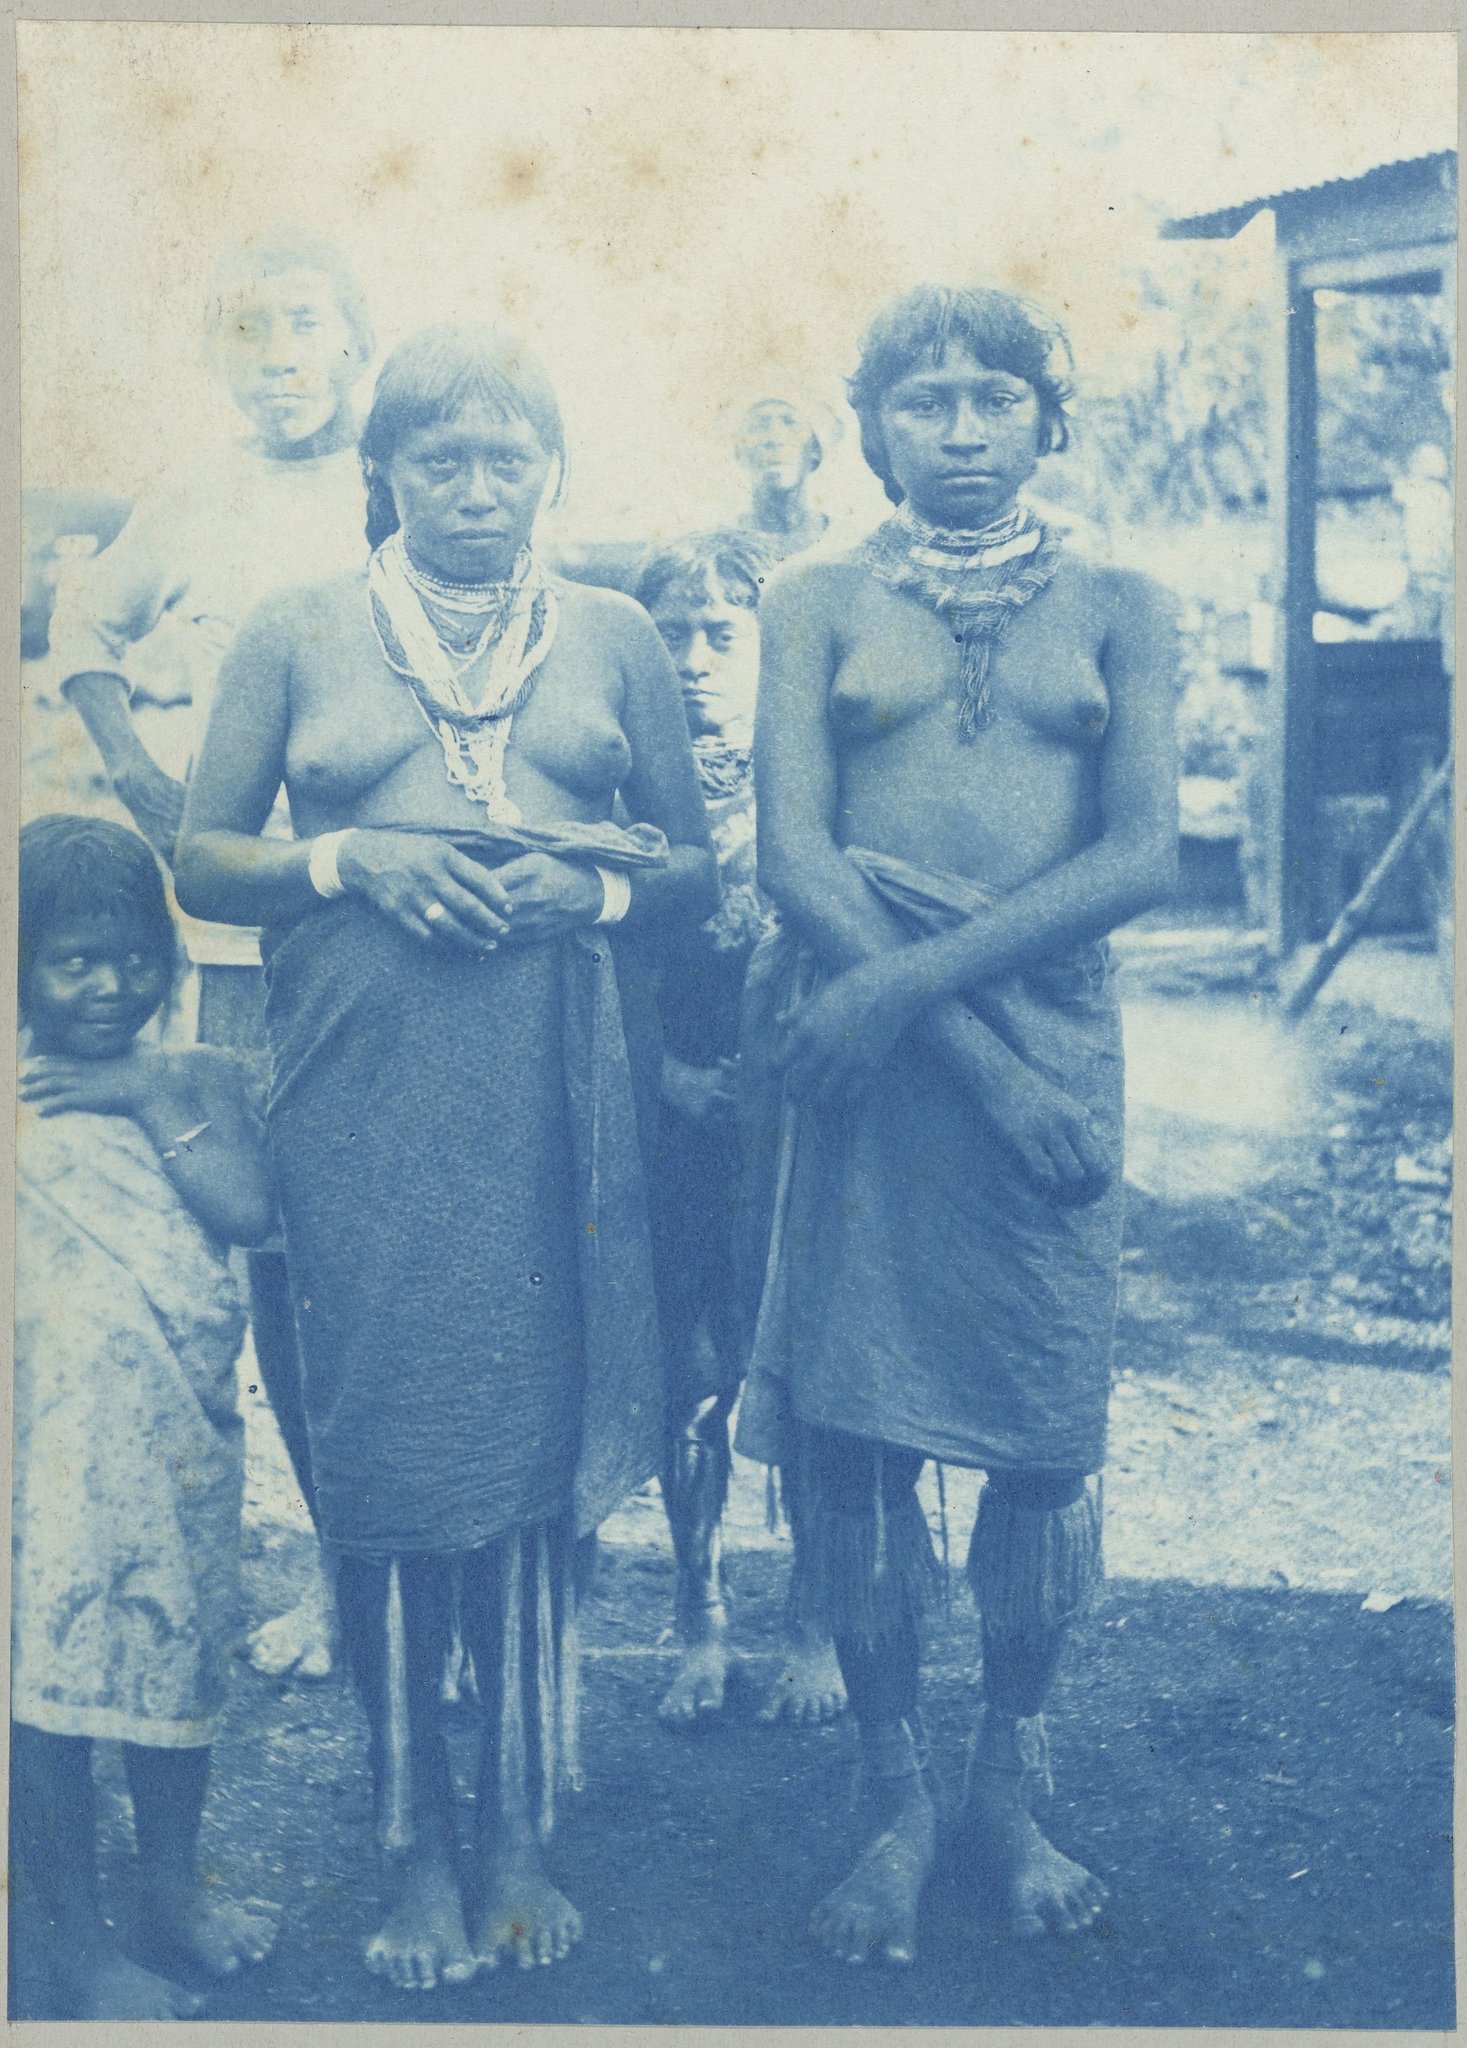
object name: photograph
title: Caräiben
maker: hendrik doijer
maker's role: engineer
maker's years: 1863-1925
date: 1903-1910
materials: photographic support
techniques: cyanotype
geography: suriname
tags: indigenous peoples of south america, suriname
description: Twee staand poserende jonge vrouwen van de Surinaamse Indiaanse Karaïben. Onderdeel van het fotoalbum Souvenir de Voyage (deel 1), over het leven van de familie Doijer in en rond de plantage Ma Retraite in Suriname in de jaren 1903-1910.